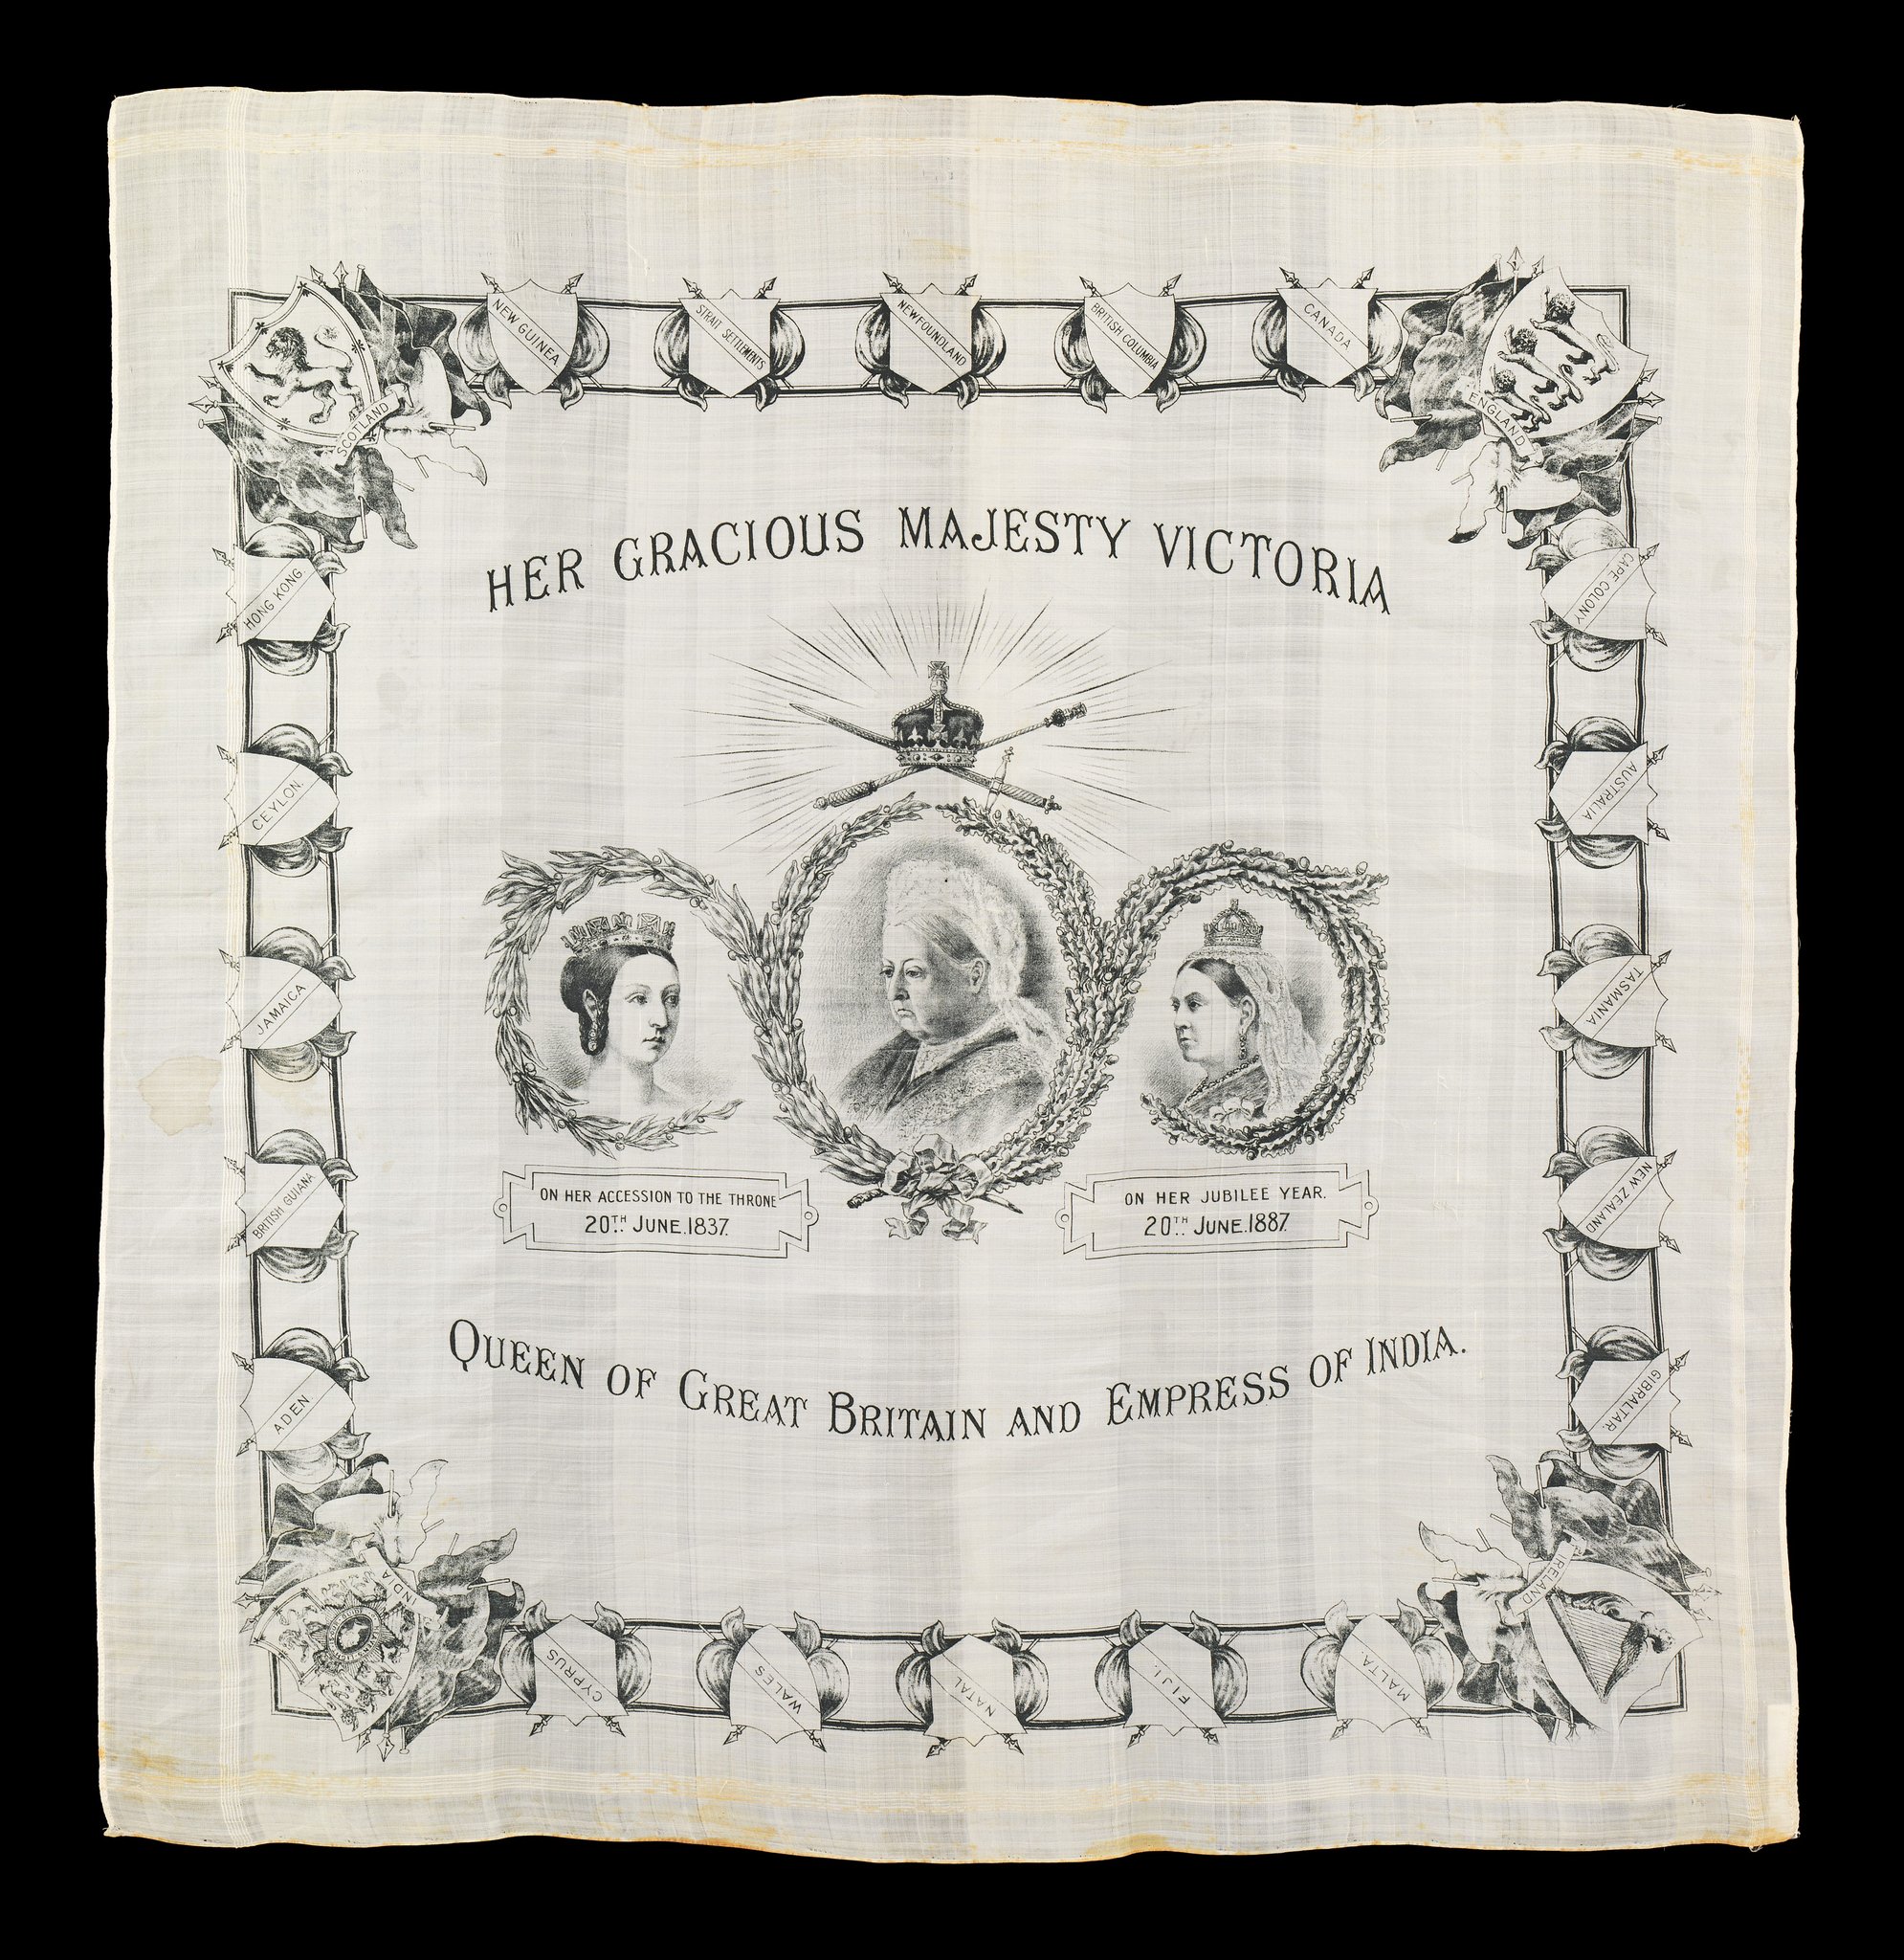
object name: scarf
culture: british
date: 1897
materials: silk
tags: women,queen victoria